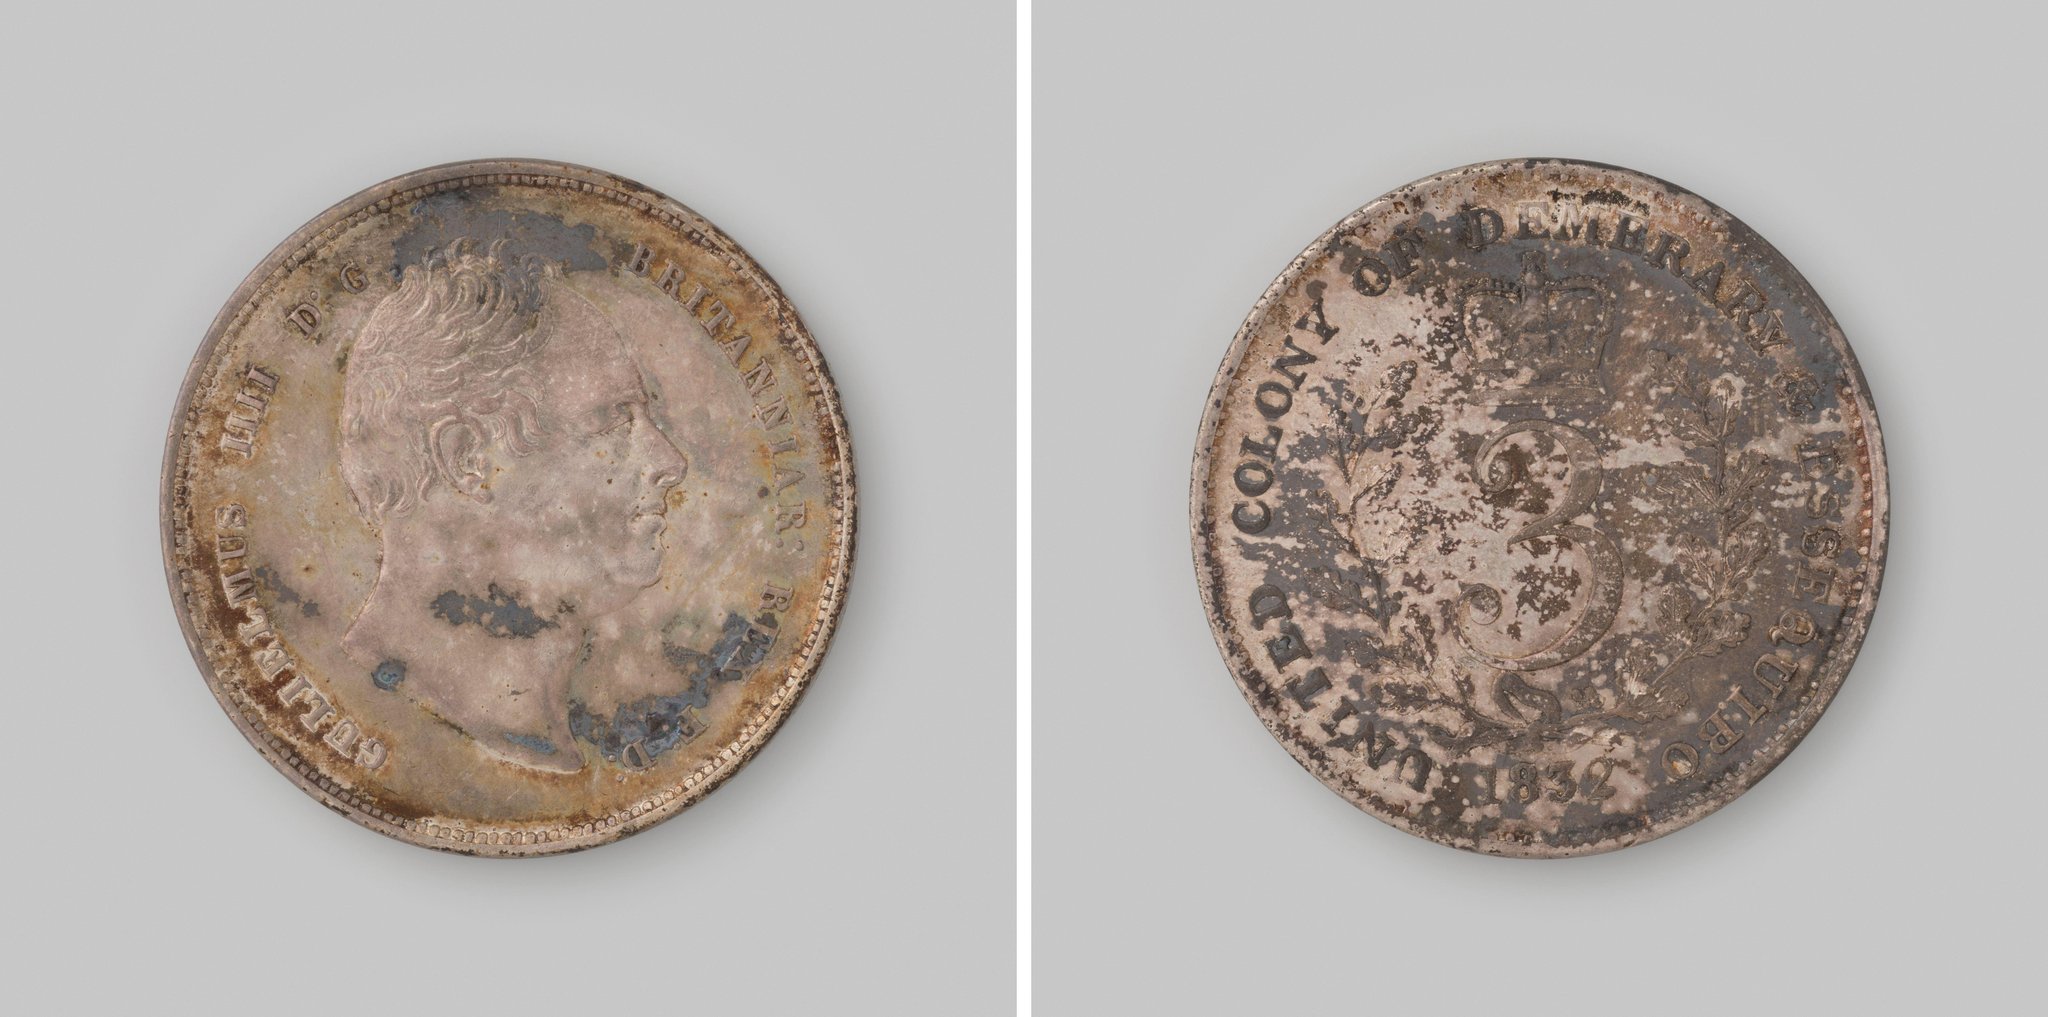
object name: coin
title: Essequibo & Demarary, koning William IV, 3 guilders, 1832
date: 1832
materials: silver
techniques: striking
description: Zilveren munt. Voorzijde: hoofd van de koning naar rechts. Keerzijde: tussen twee samengebonden takken waarde-aanduiding: 3, waarboven kroon. Jaartal onderaan in omschrift. Gladde rand.